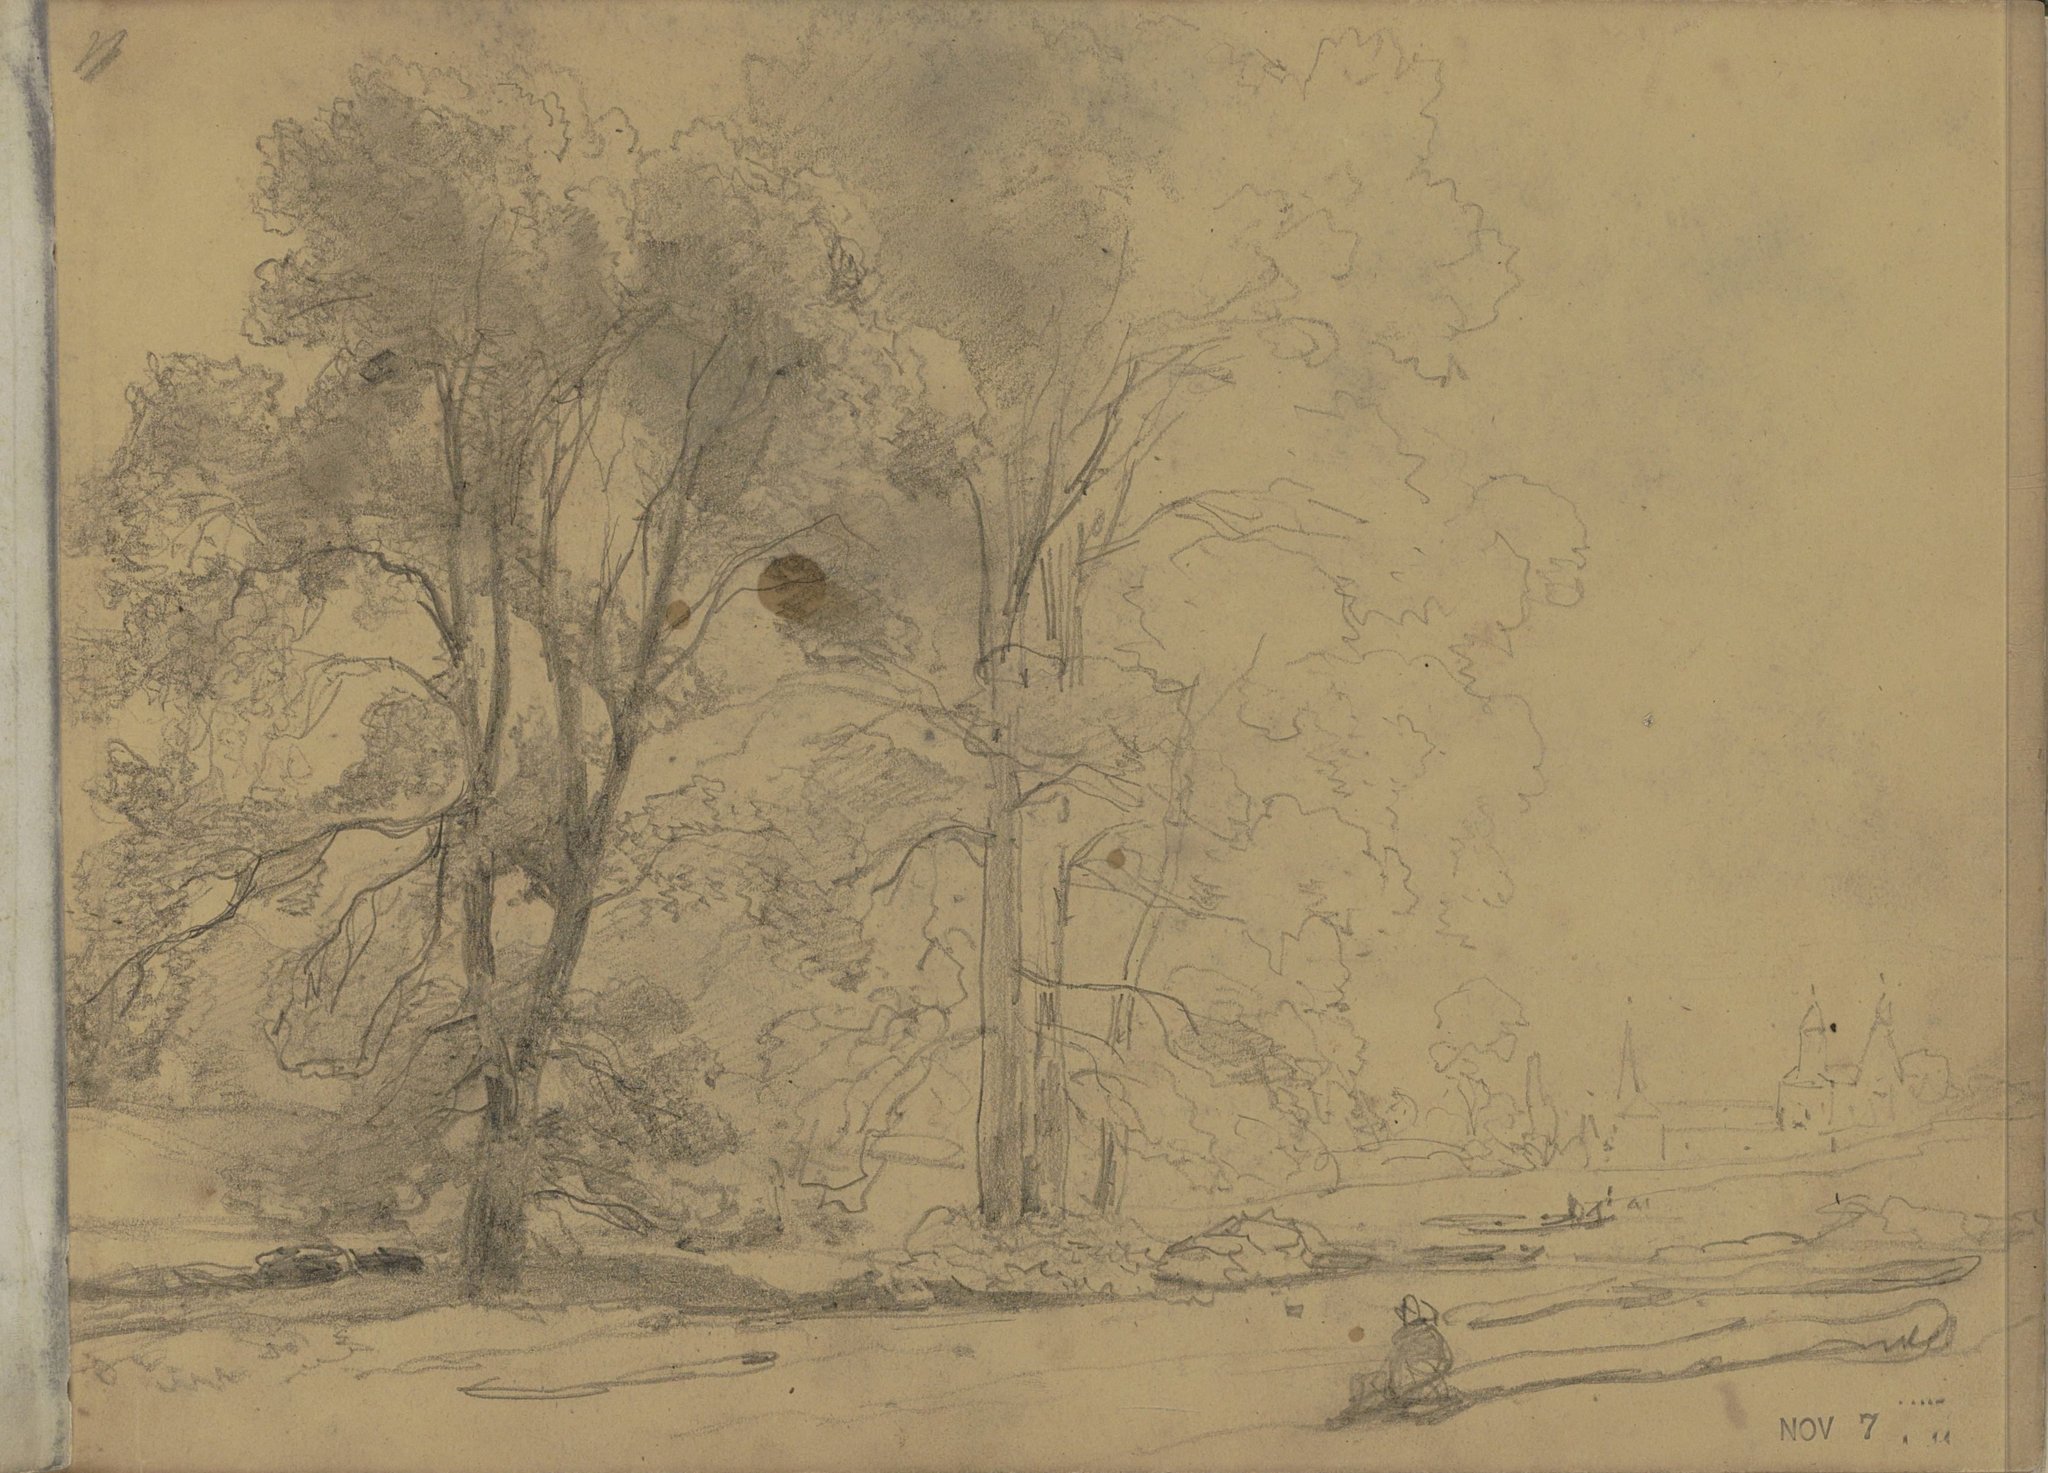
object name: sketchbook leaf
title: Landschap met bomen en een rustende reiziger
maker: willem roelofs (i)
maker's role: draughtsman, painter, print maker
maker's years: 1822-1897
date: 1846-1851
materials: paper, pencil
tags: (traveller) resting in the open air, prospect of village, silhouette of village (+ city(-scape) with figures, staffage)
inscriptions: date: ‘NOV 7 , ,,’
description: Op de achtergrond het silhouet van een dorp of stad. Blad 2 recto uit een schetsboek met 25 bladen.